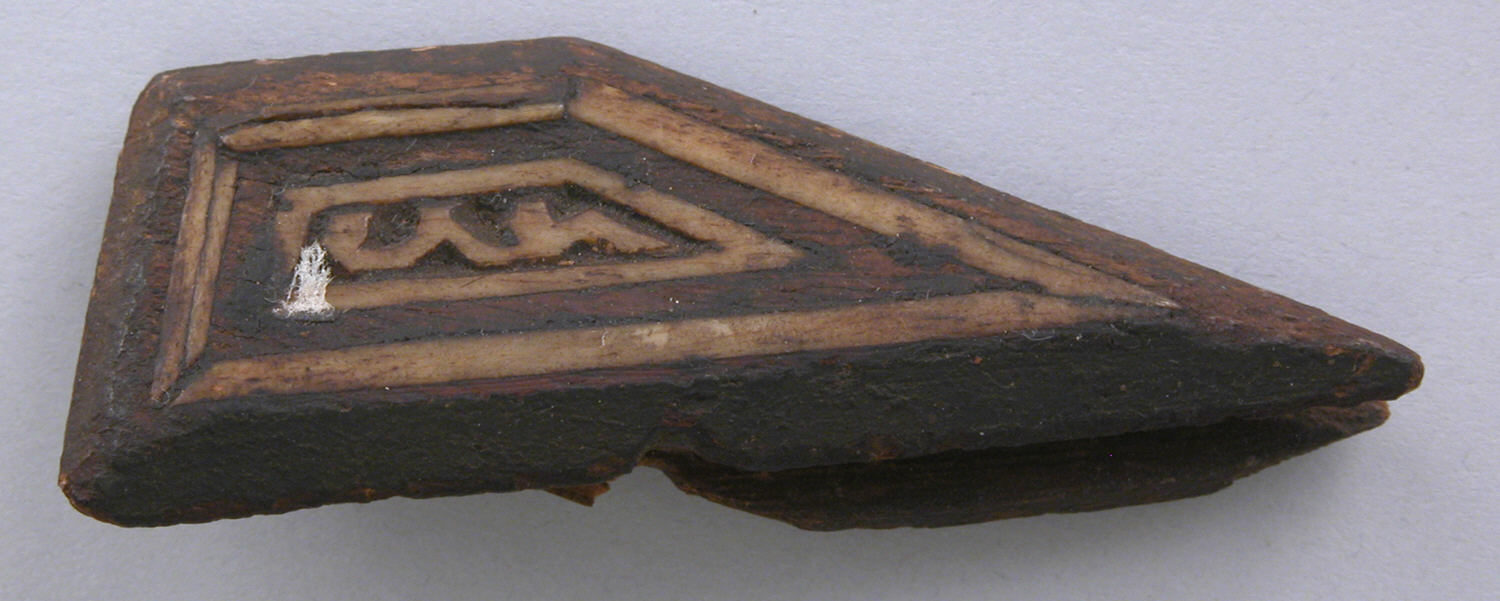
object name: panel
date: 1301-1500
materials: ivory, wood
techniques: carving, inlay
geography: egypt